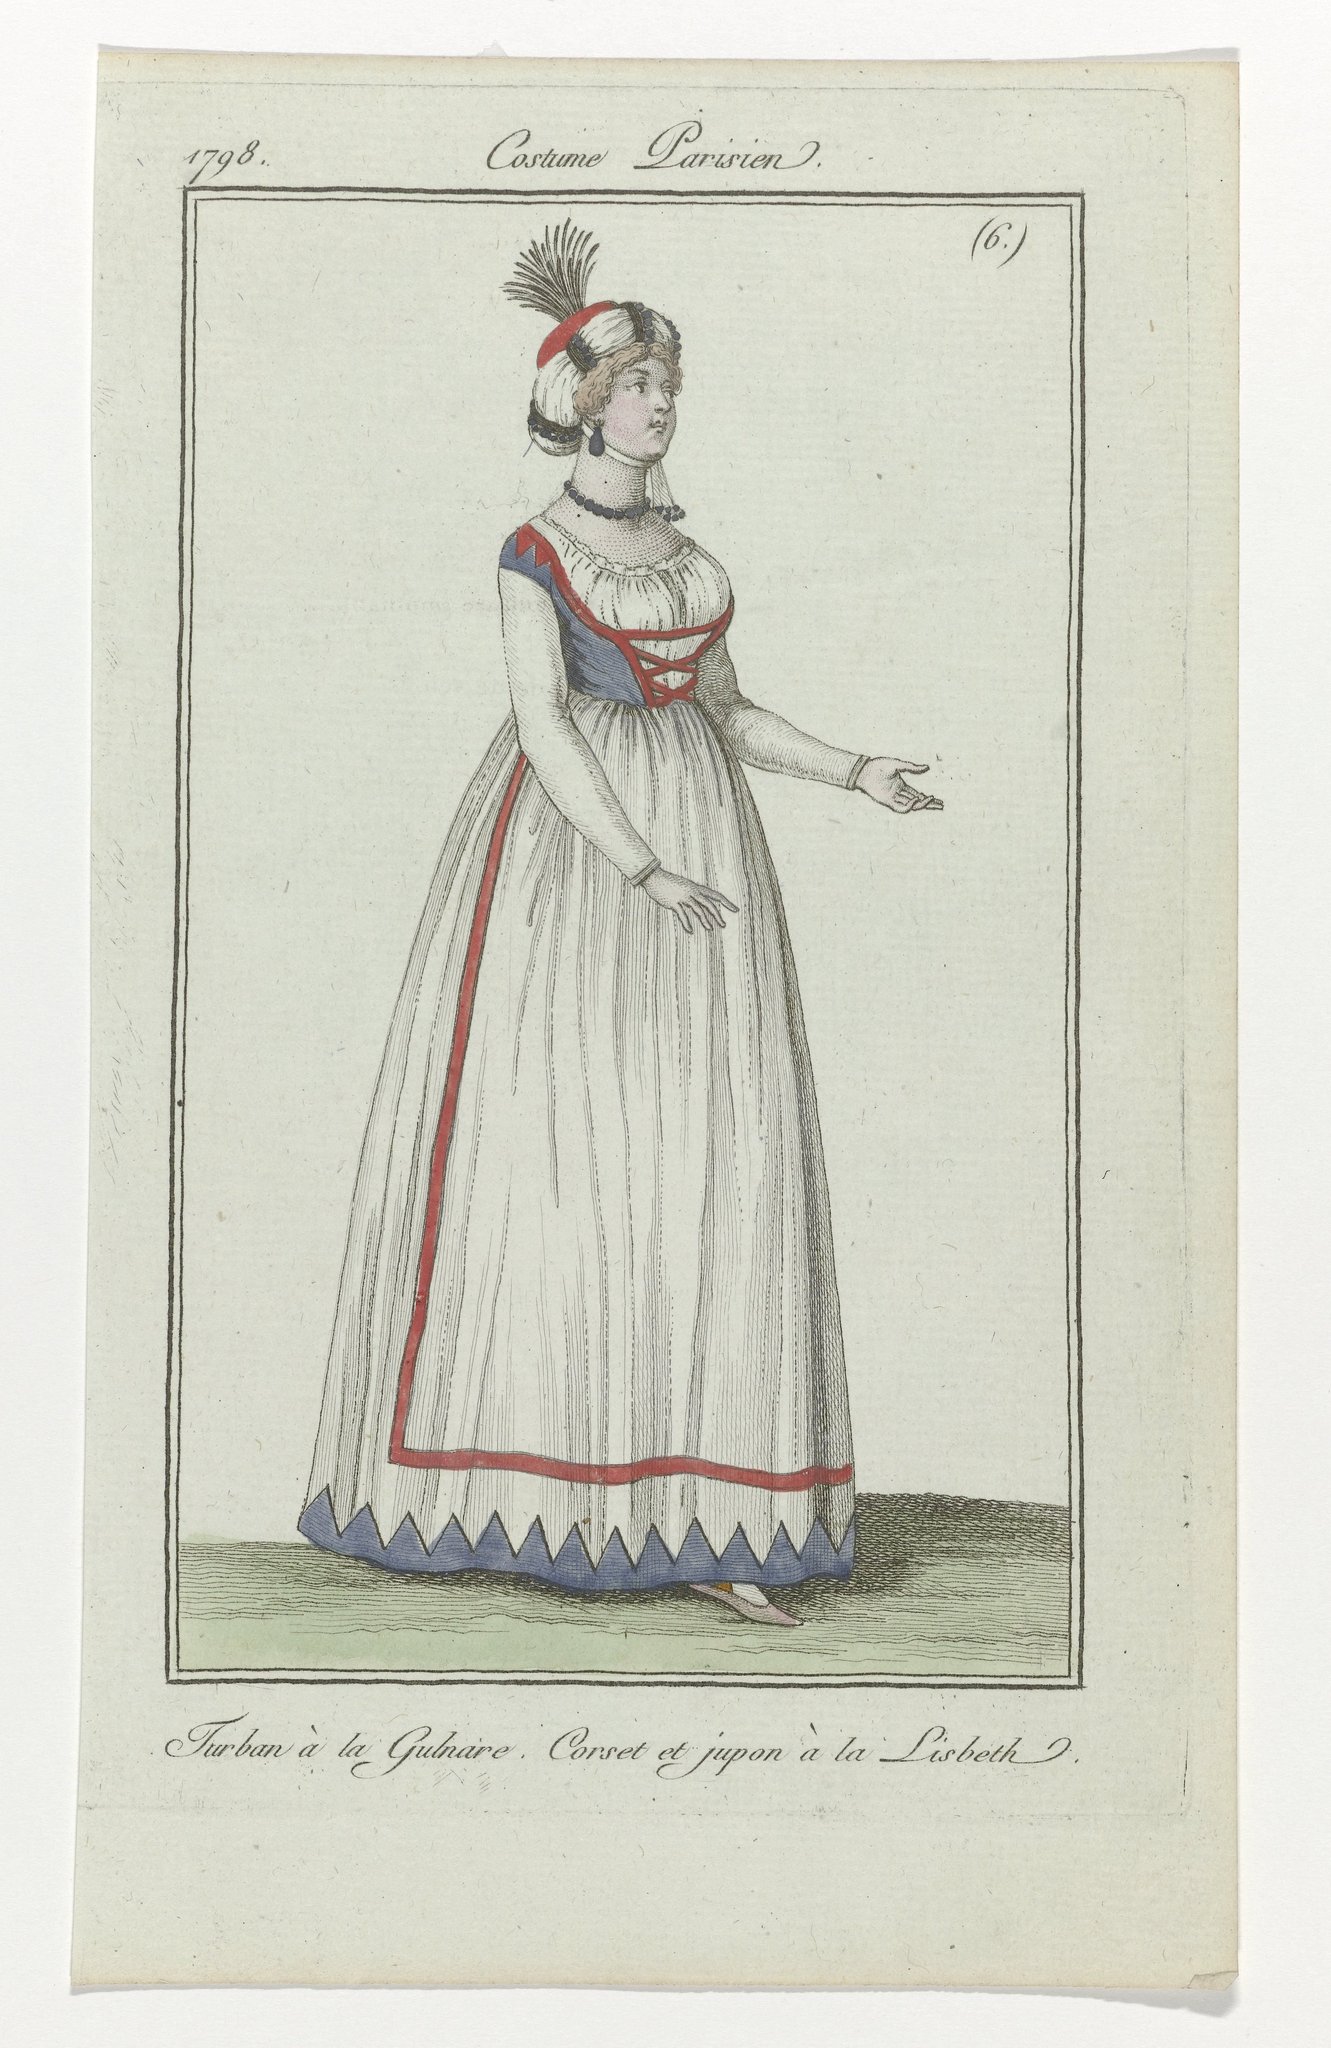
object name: fashion print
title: Journal des Dames et des Modes, Costume Parisien, 11 février 1798, (6) : Turban à la Gulnar (...)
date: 1798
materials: paper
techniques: engraving, hand coloring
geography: paris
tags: ear-rings (+ women's clothes), head-gear: turban (+ women's clothes), fashion plates, shoes, sandals (+ women's clothes), skirt (+ women's clothes), necklace (+ women's clothes), clothing for the upper part of the body (with name) (+ women's clothes)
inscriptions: title: ‘Costume Parisien.’, caption: ‘Turban à la Gulnar. Corset et jupon à la Lisbeth.’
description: 'Turban à la Gulnare'. Lijfje en een rok 'à la Lisbeth'. Verdere accessoires: oorbel in het rechteroor, collier, platte schoen met puntige neus. De prent maakt deel uit van het modetijdschrift Journal des Dames et des Modes, uitgegeven door Sellèque, Parijs, 1797-1839.